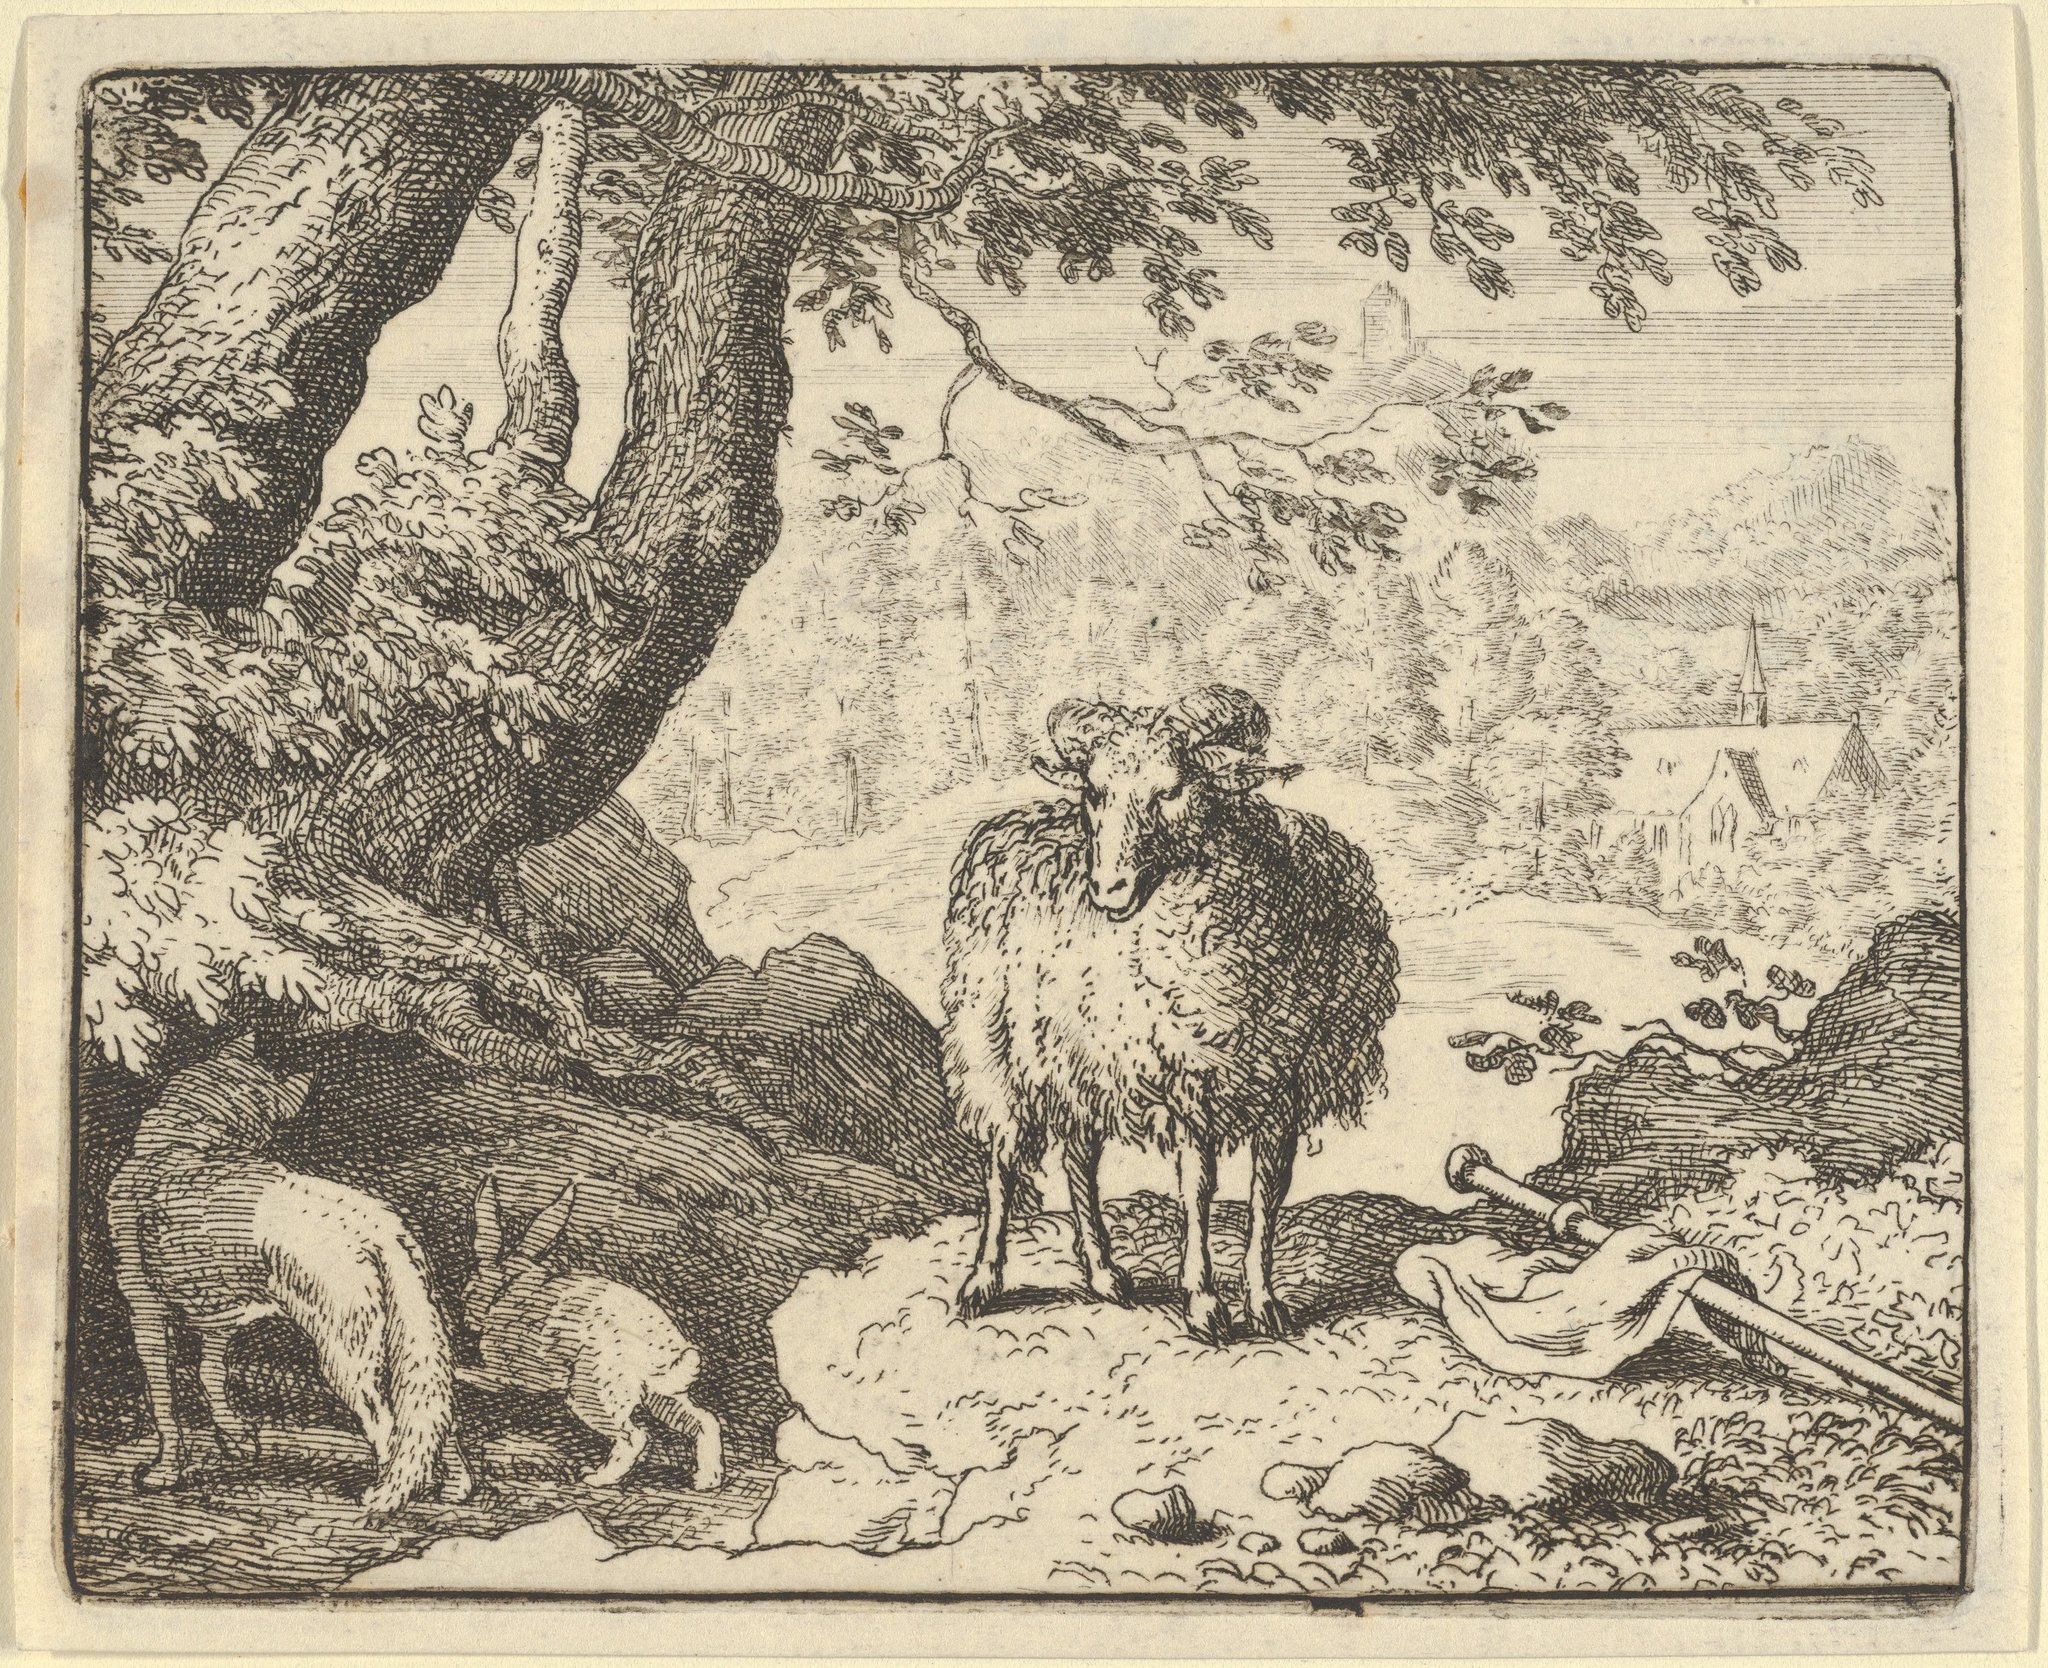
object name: print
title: Renard Convinces the Rabbit to Enter His Burrow and Kills Him from Hendrick van Alcmar's Renard The Fox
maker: allart van everdingen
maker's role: artist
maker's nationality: dutch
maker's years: 1621-1675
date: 1650-1675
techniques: engraving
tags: foxes,rabbits,sheep,landscapes